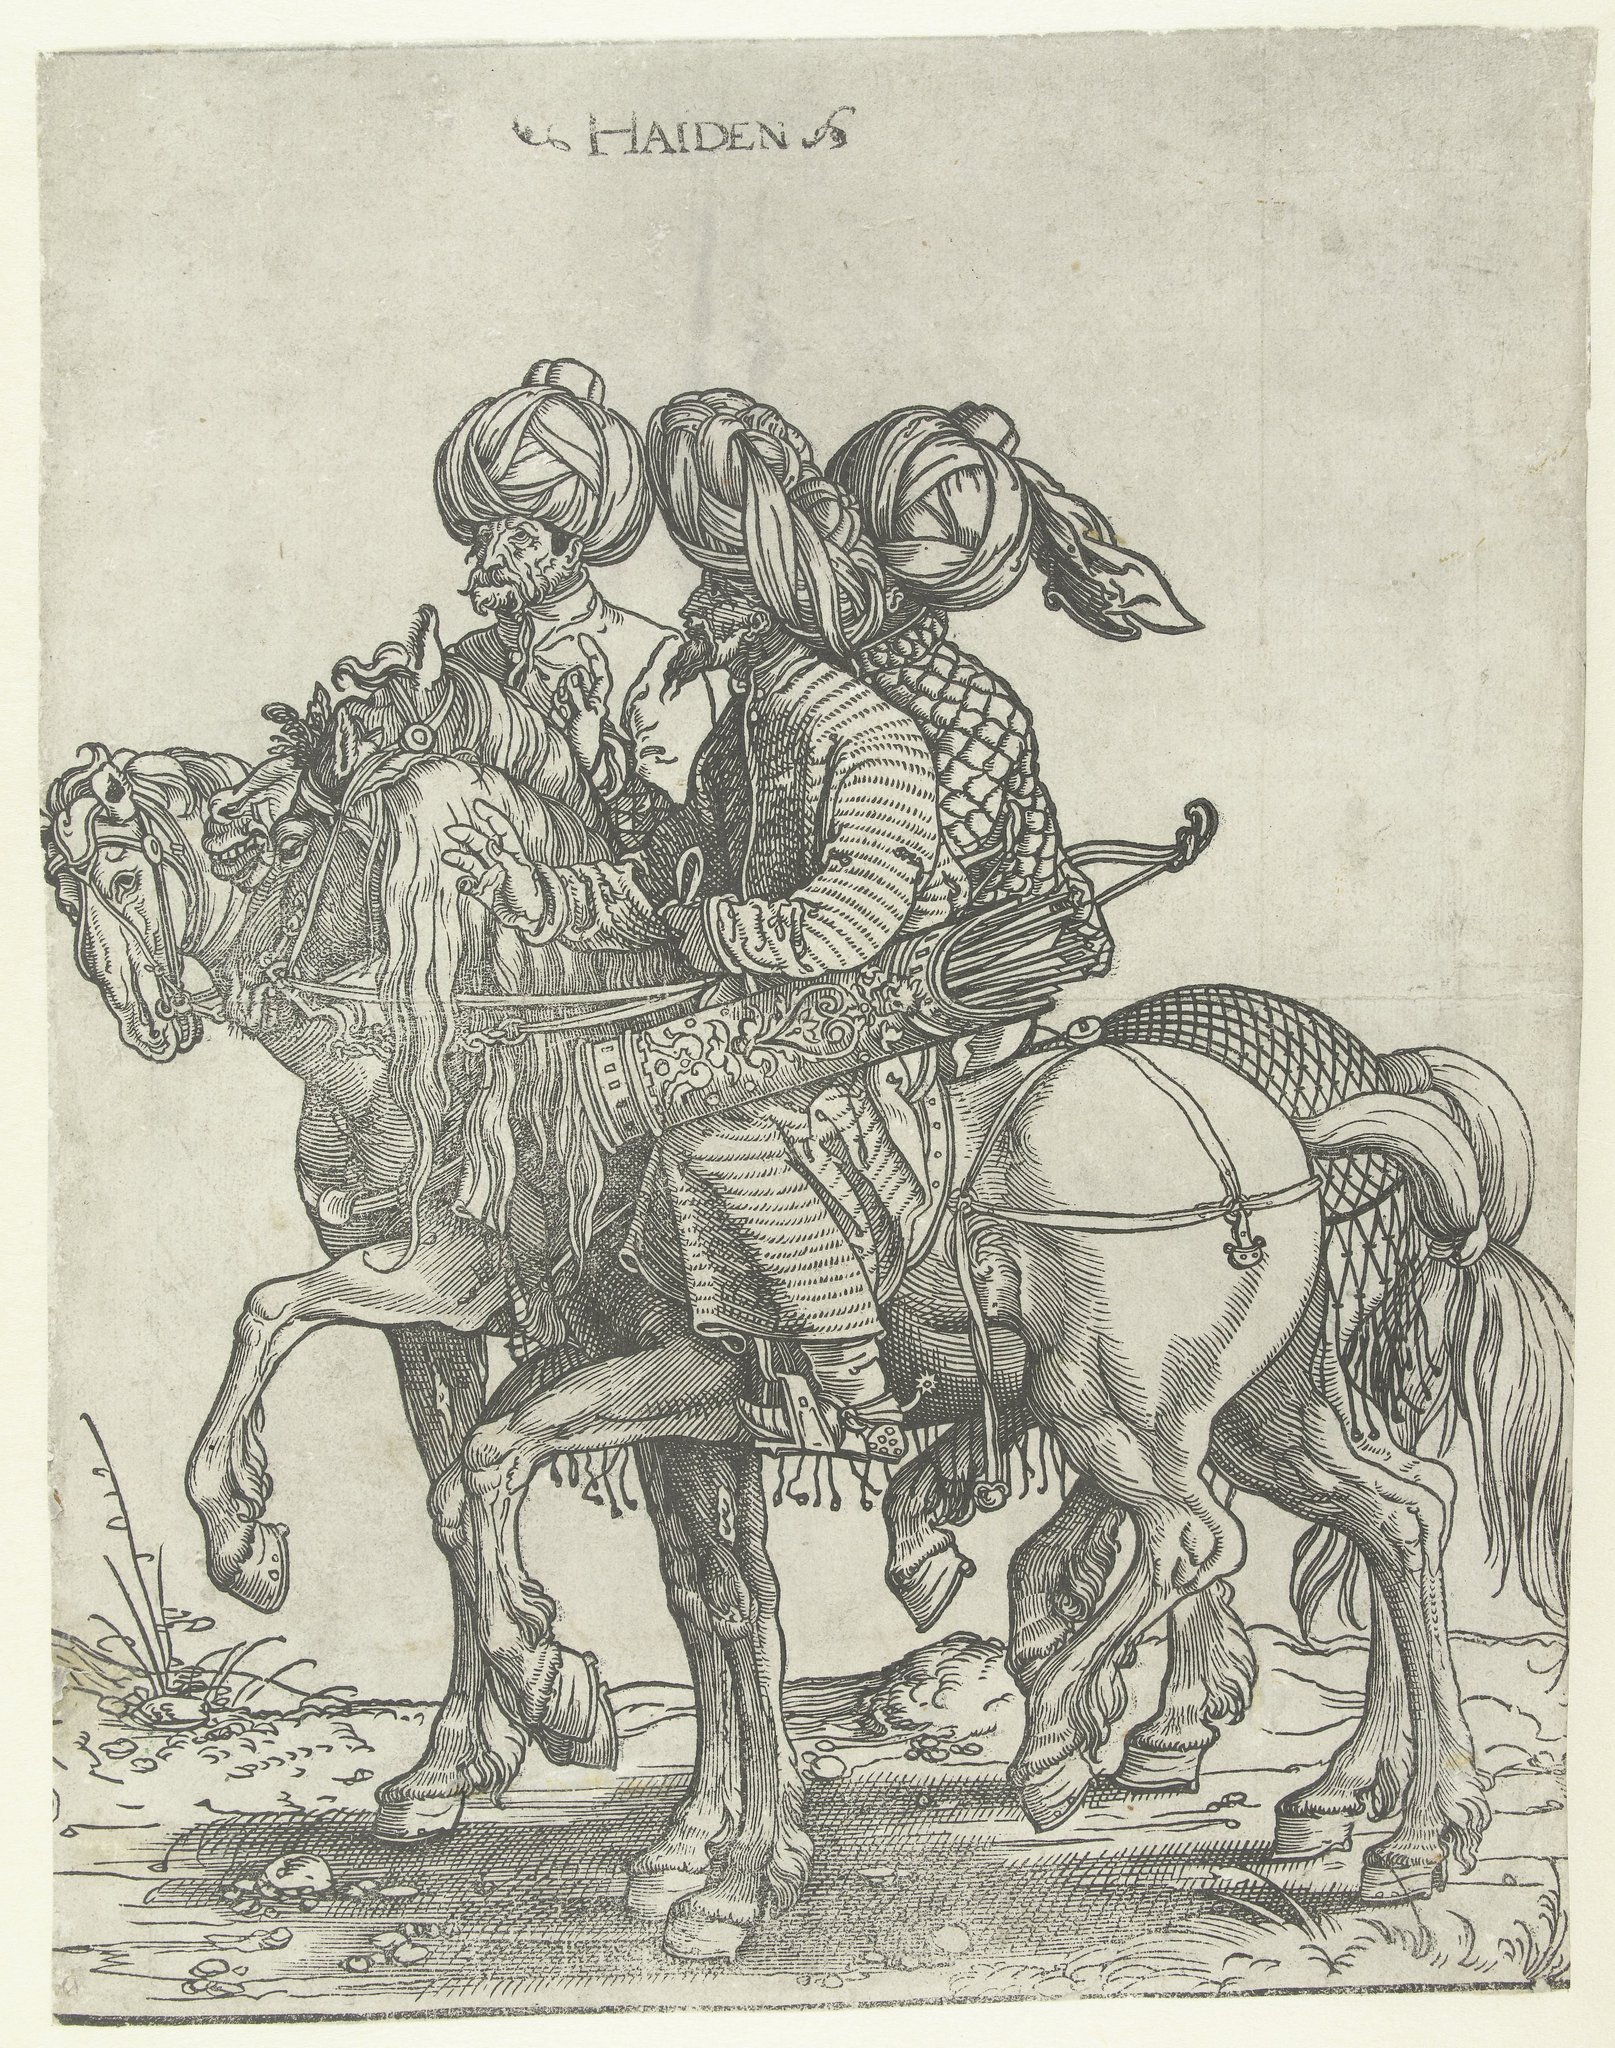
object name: print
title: Soleiman met zijn gevolg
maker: jan swart van groningen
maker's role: draughtsman, painter, print maker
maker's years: 1500-1562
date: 1526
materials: paper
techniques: woodcut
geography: low countries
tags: archer's weapons: bow and arrow, asiatic races and peoples: turks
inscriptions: collector's mark: Lugt 2228, inscription: ‘Jeune greeff...’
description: Uit serie van vijf prenten met een stoet van Turken. Drie mannen te paard, met tulband op hoofd en koker met pijlen en boog.